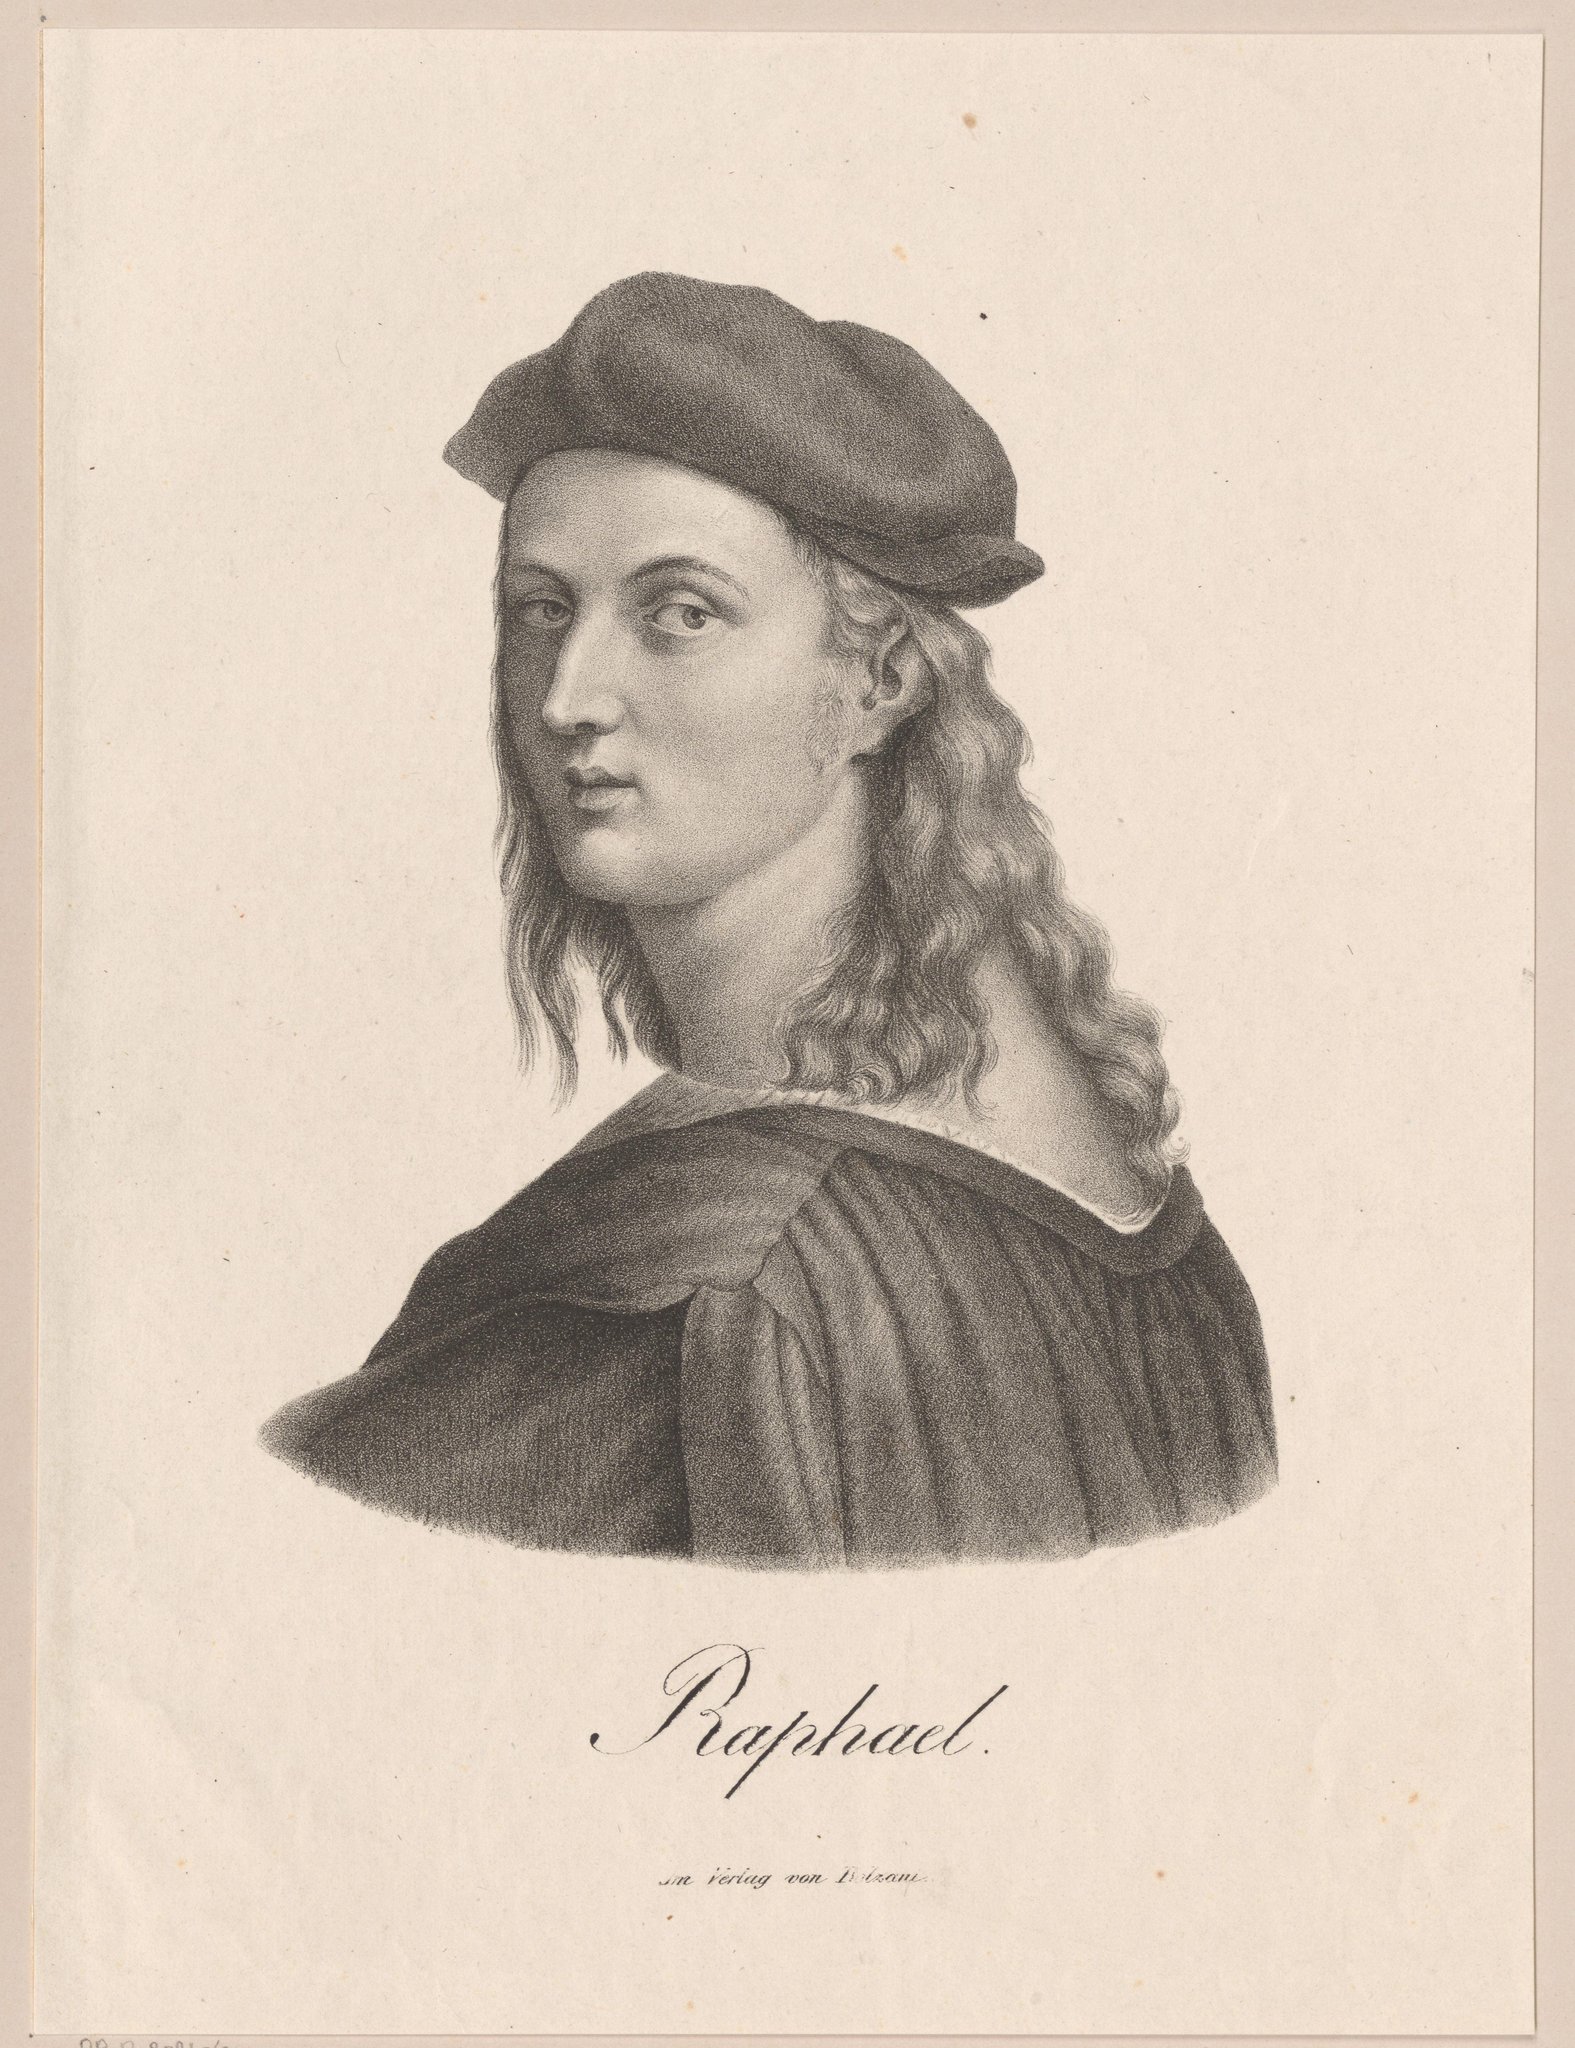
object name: print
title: Portret van Rafaël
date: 1795-1849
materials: paper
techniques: lithograph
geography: padua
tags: rome, painter, rafaël, historical persons